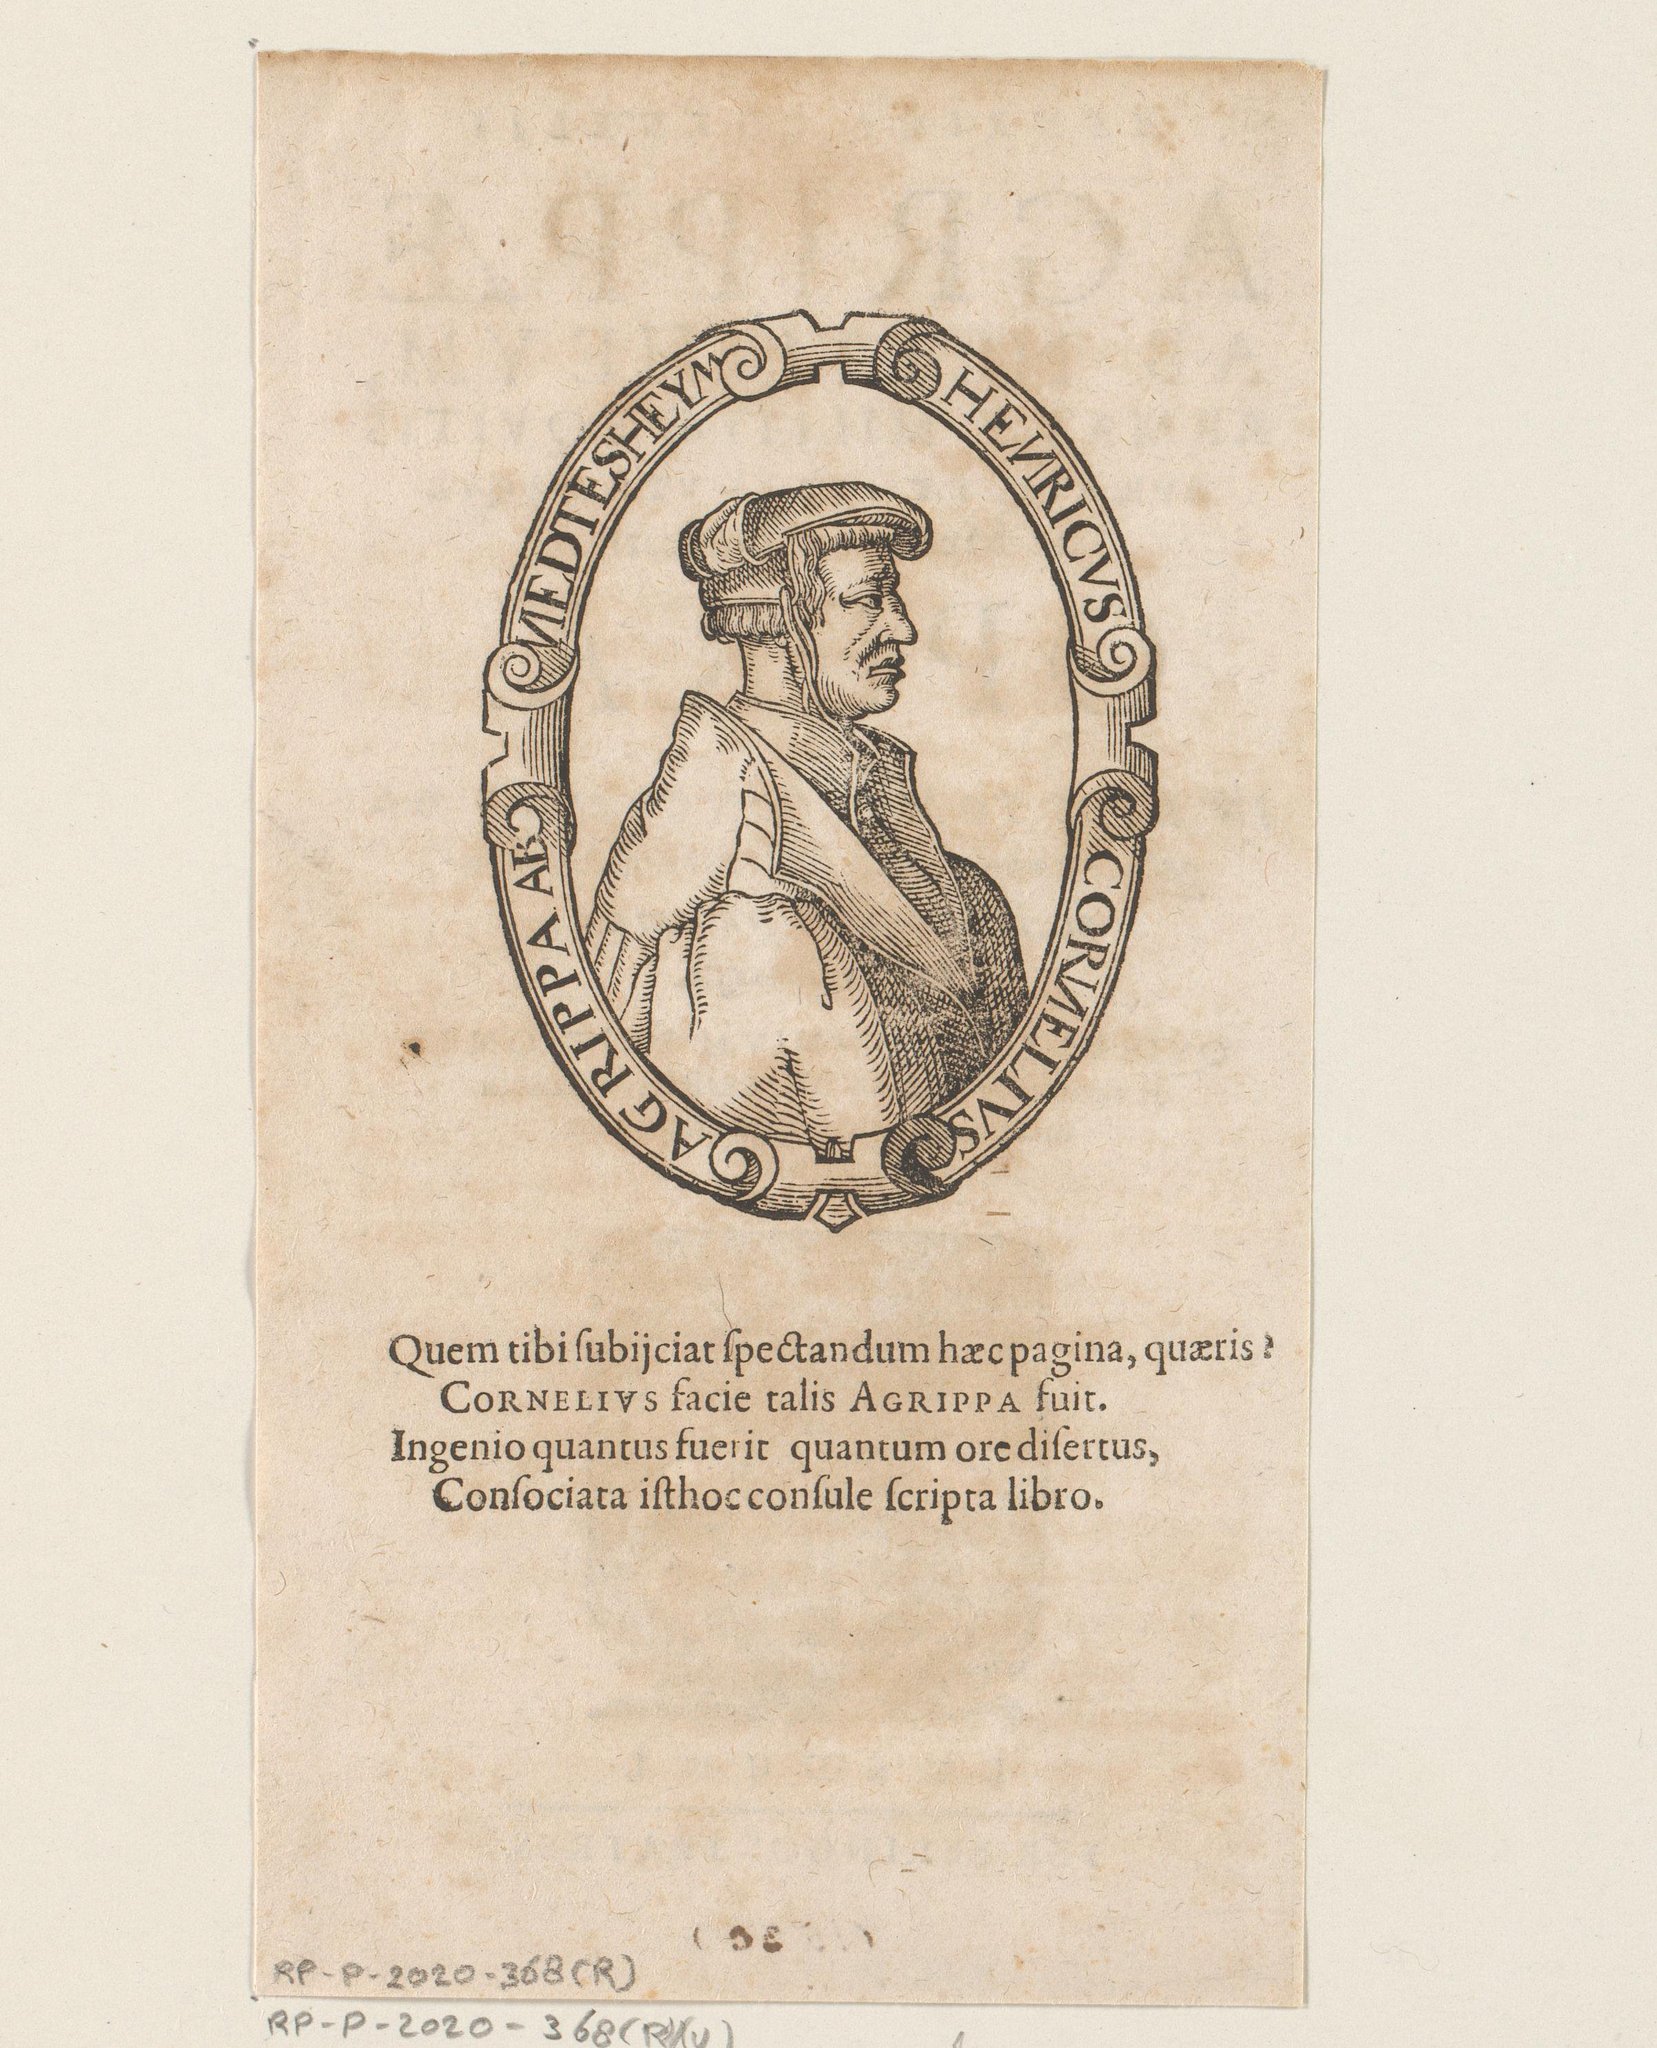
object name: print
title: Portret van Heinrich Cornelius Agrippa von Nettesheim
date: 1545-1556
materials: paper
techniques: letterpress printing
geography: lyon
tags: historical persons, portrait of a writer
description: Prent uit: Agrippa von Nettesheim, Heinrich Cornelius. Opera. In duos tomos concinne digesta (...). Lyon: Godefroy en Marcellin Beringen, s.a. Prent ook gebruikt in andere werken van dezelfde auteur.